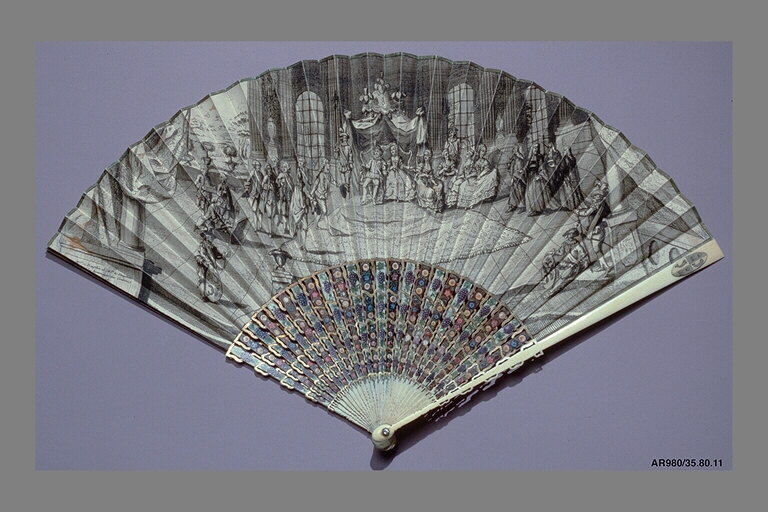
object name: fan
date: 1770-1774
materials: ivory, paper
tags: men,women